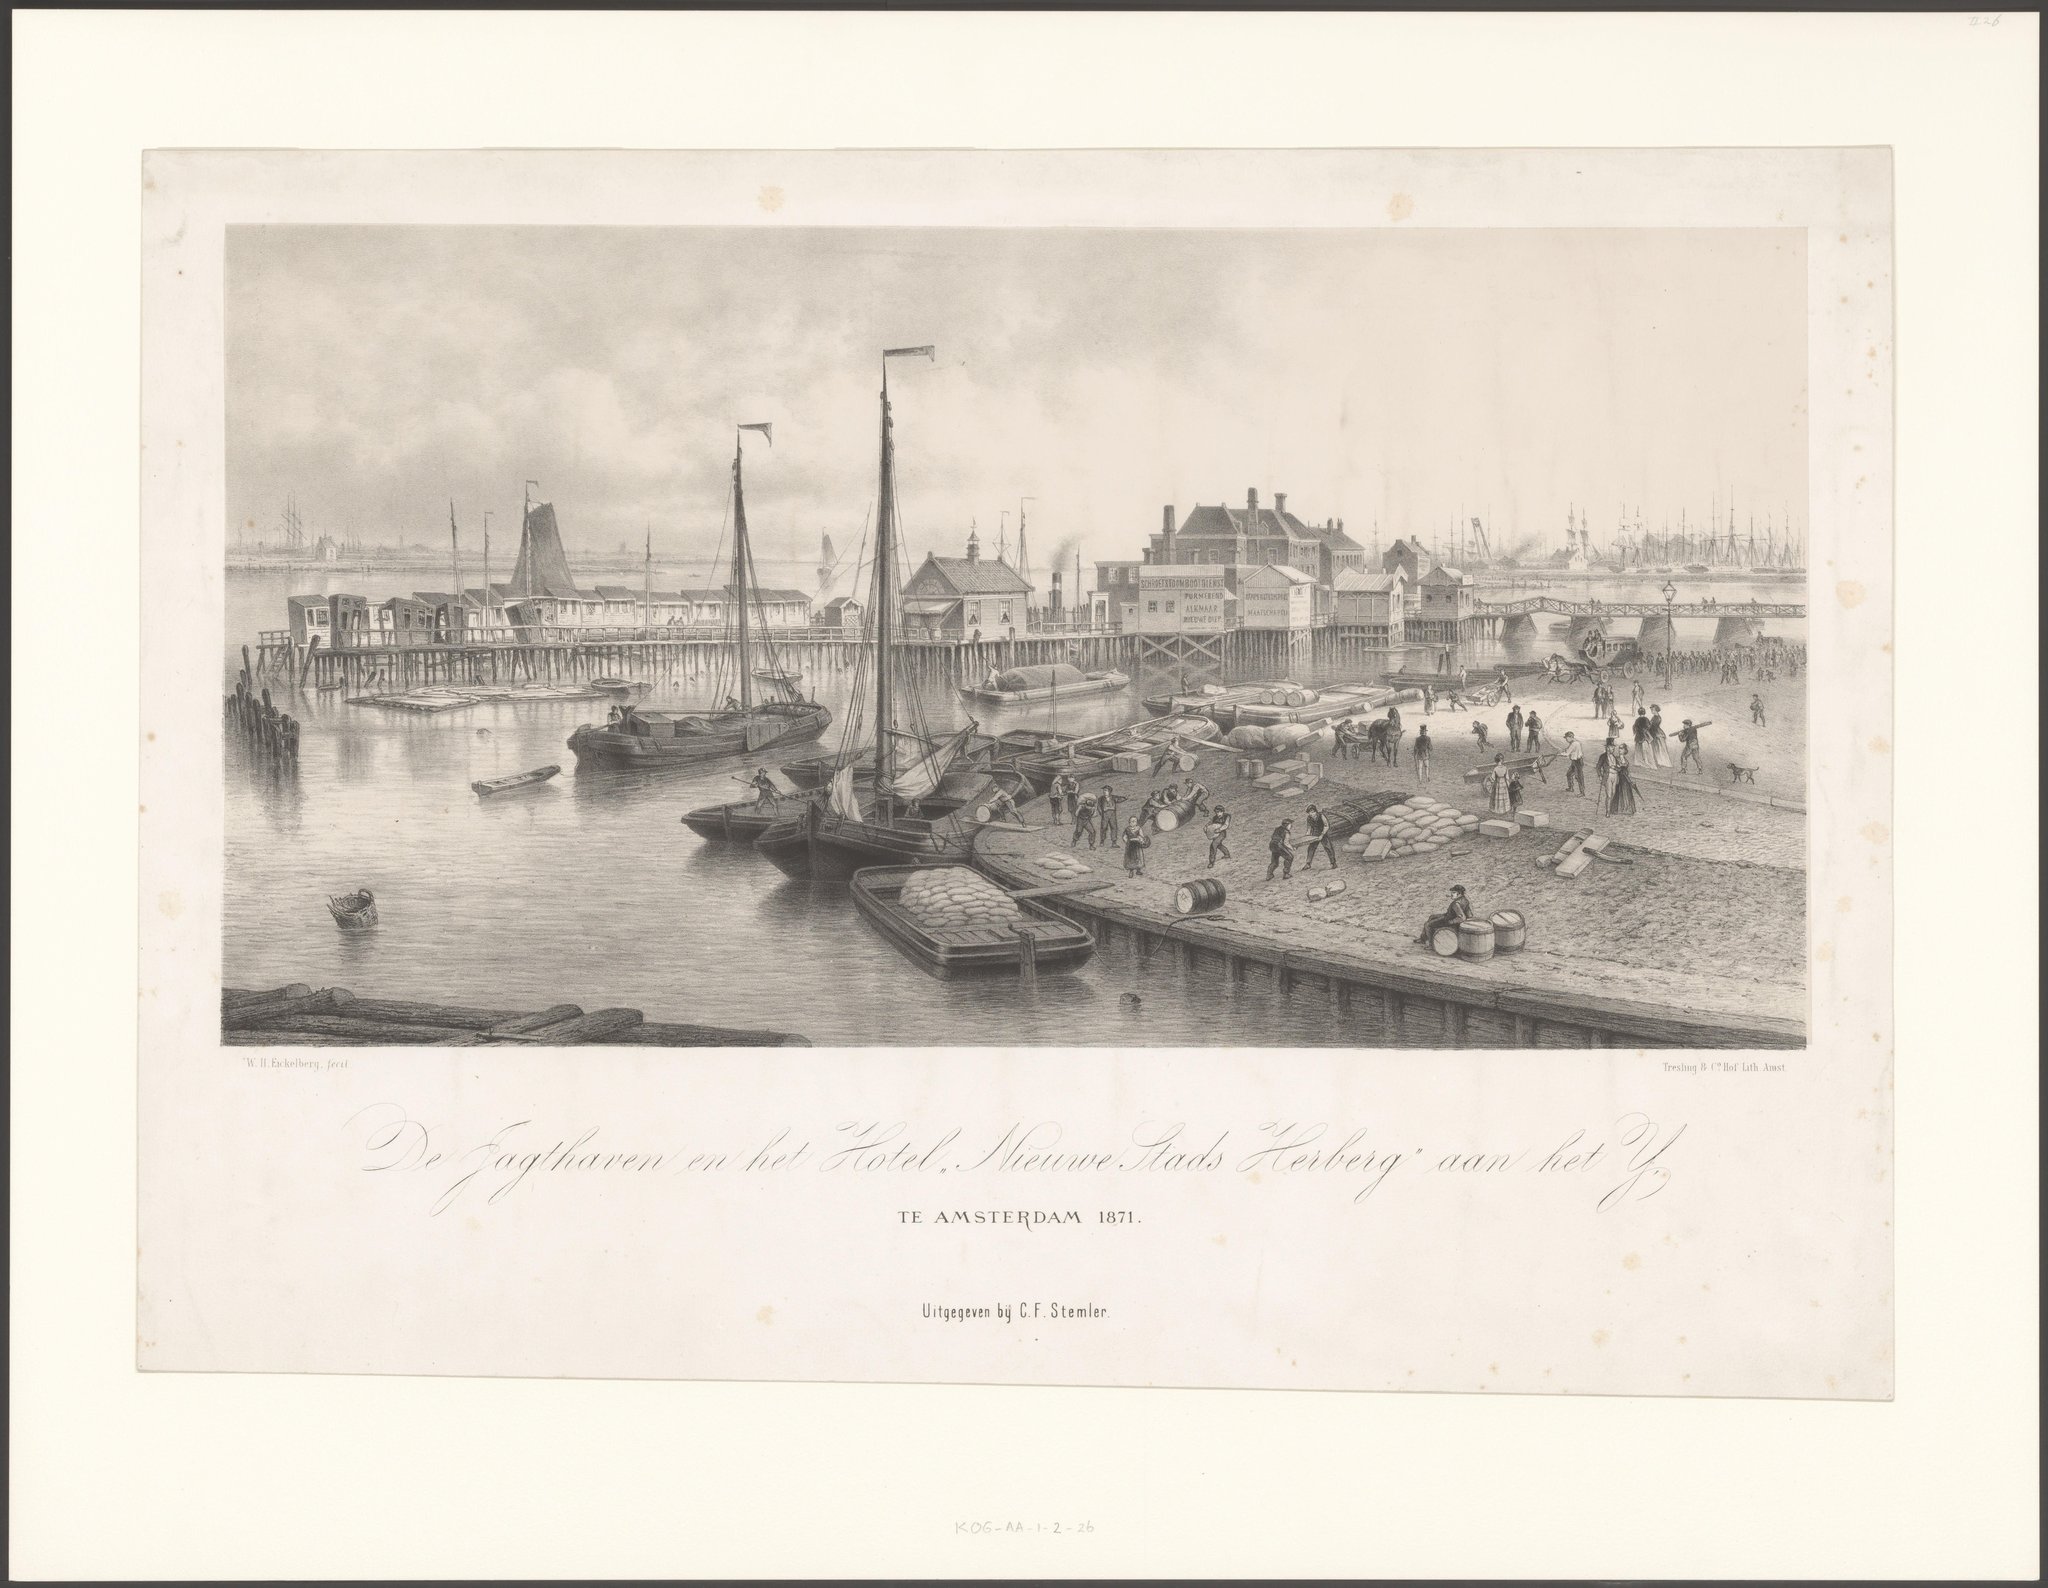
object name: print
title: Gezicht op de Nieuwe Stadsherberg aan de Jachthaven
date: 1871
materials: paper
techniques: tone lithography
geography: amsterdam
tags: city-view in general; 'veduta', river, ships (in general) - cc - more than one ship, hotel, hostelry, inn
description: Onderwerpsrubriek binnen de Atlas Amsterdam: Gezichten van het IJ op het Oostelijk gedeelte der stad, Nieuwebrug tot Zeeburg.